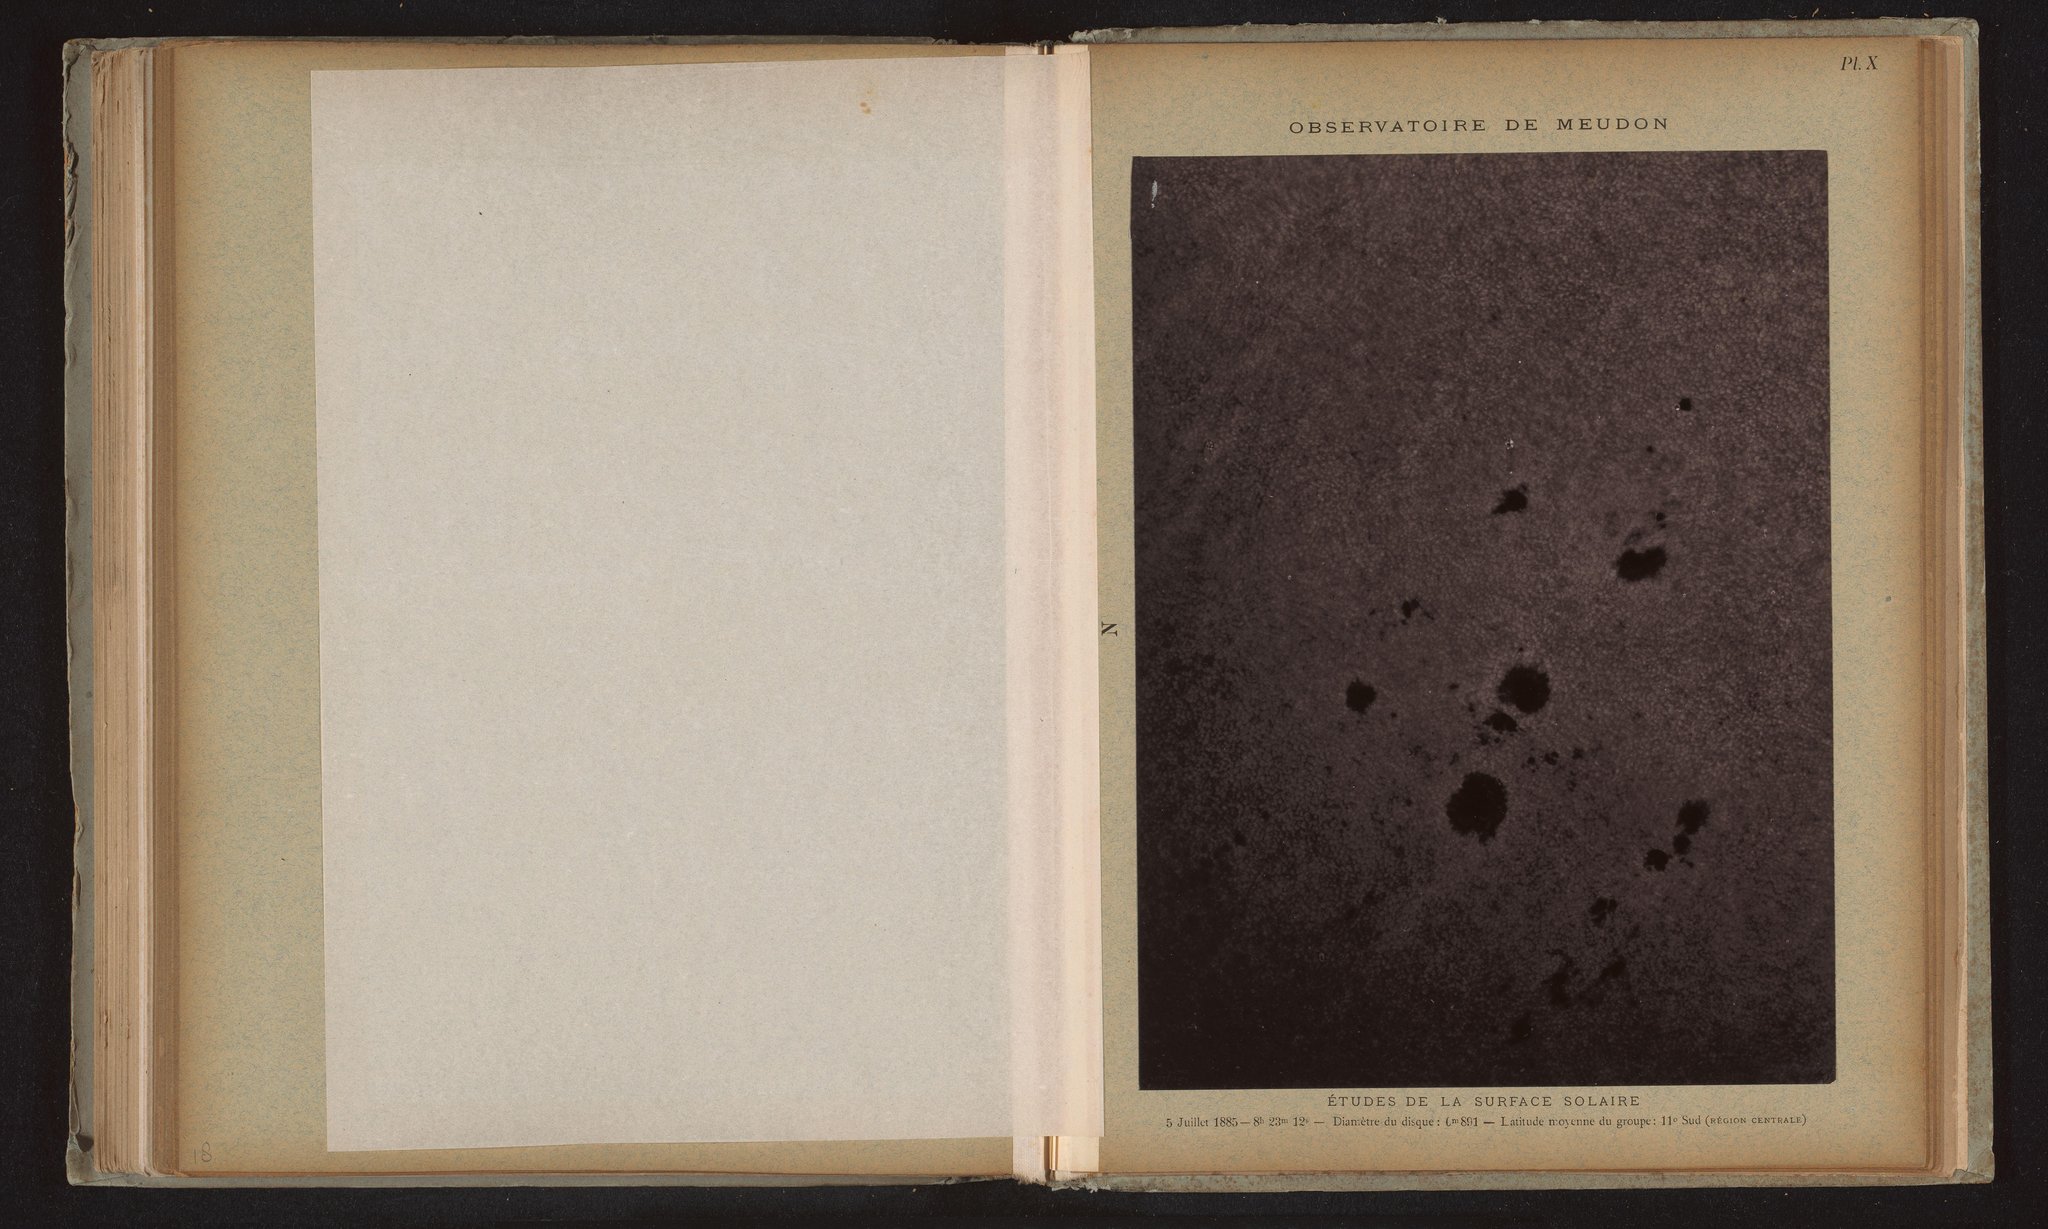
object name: photograph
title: Studie van het zonneoppervlak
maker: Anonymous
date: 1885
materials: paper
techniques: carbon print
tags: physical aspects of the sun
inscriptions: inscription: ‘5 Julliet 1885 - 8h 23m12s - Diamètre du disque: 0m891- Latitude moyenne du groupe: 11°Sud (Région centrale)’, inscription: ‘Pl. X’